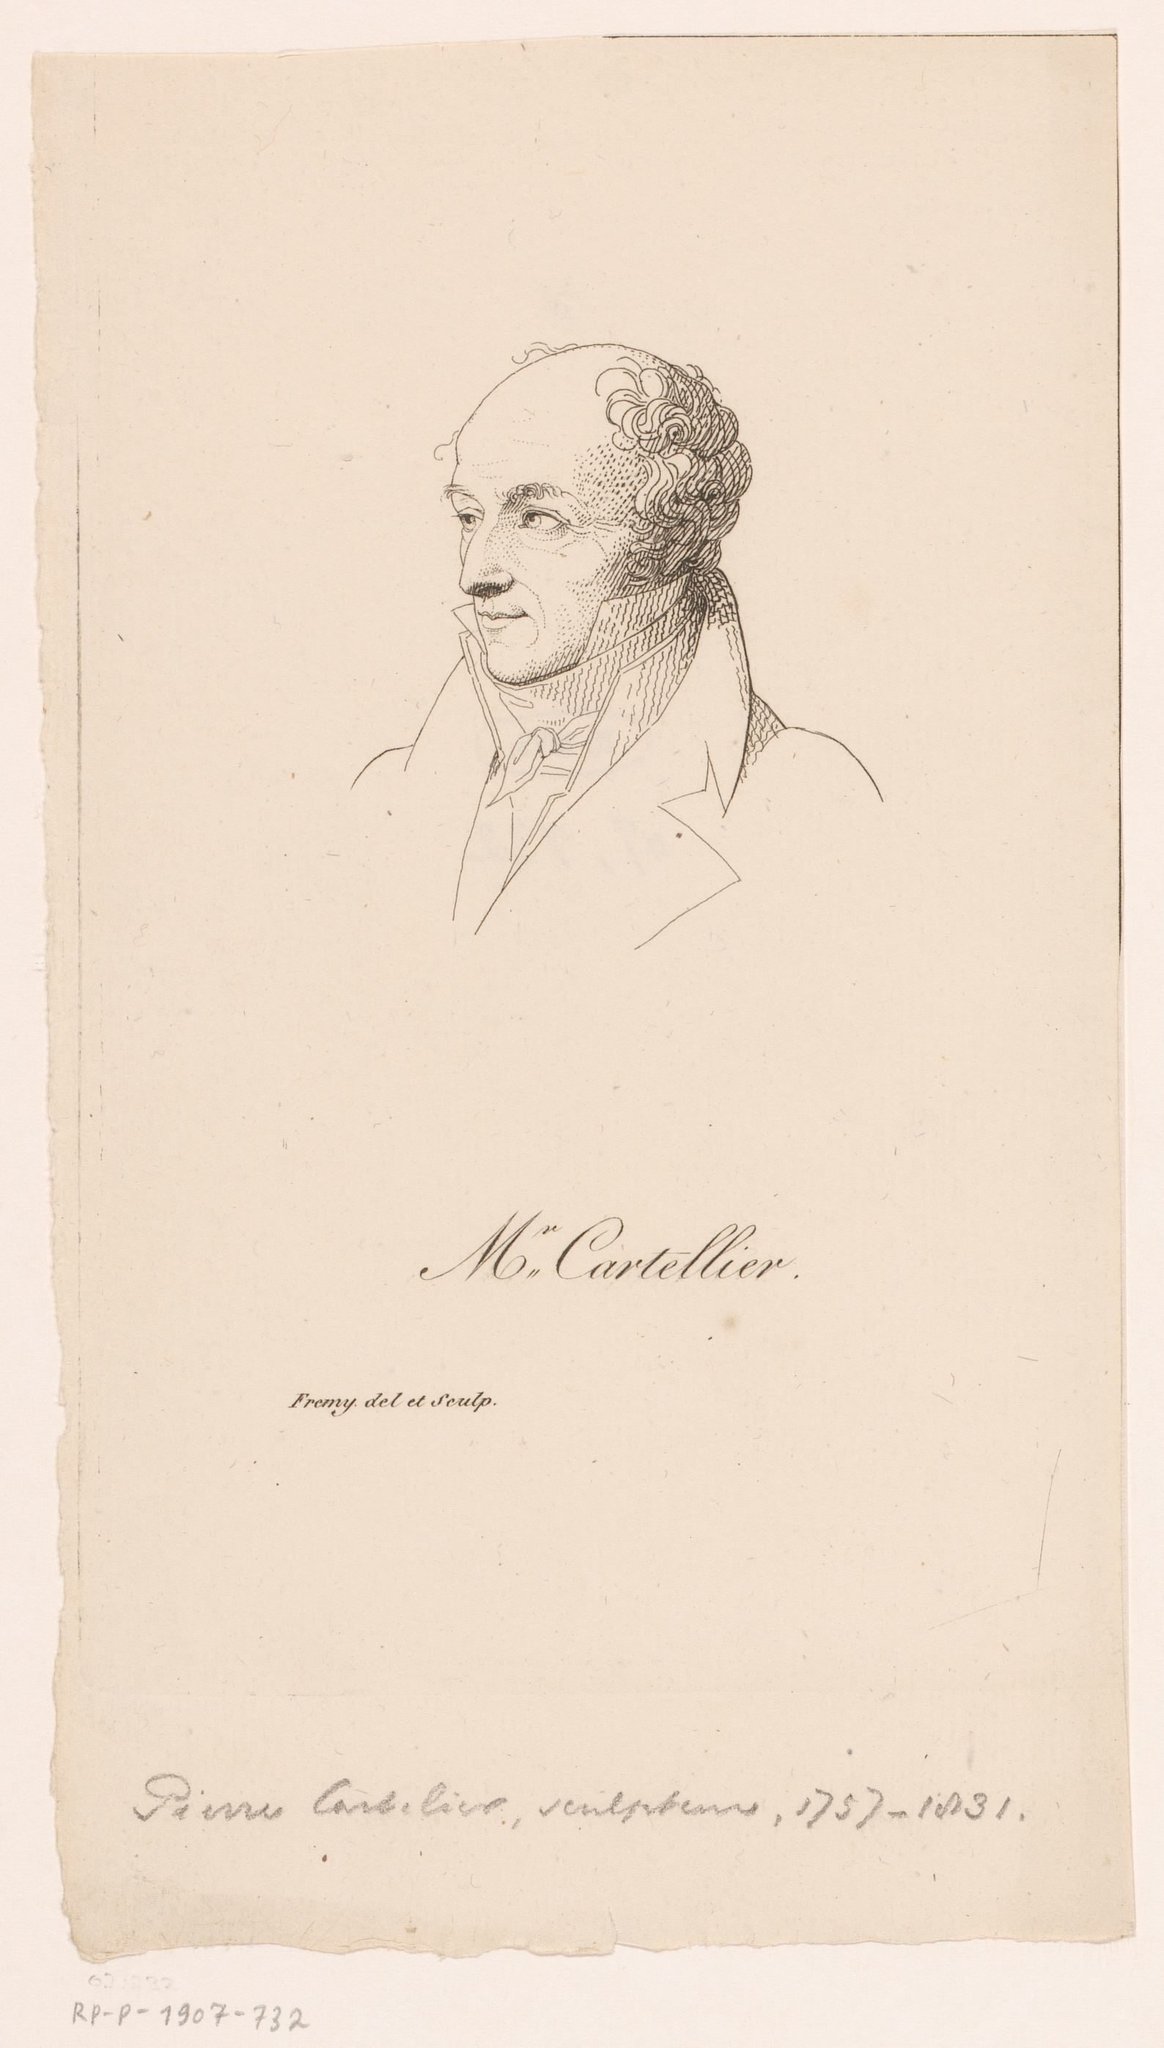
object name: print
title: Portret van Pierre Cartellier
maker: jacques noël marie frémy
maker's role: print maker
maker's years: 1782-1867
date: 1815-1817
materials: paper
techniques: etching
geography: france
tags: paris, sculptor, pierre cartellier, portrait, self-portrait of sculptor, historical persons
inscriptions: collector's mark: Lugt 2228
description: Mogelijk prent uit: Frémy, Jacques Noël Marie. Croquis de portraits des personnages remarquables dans tous les genres, dessinés et gravés. Parijs: Jacques Noël Marie Frémy, 1815-1817.